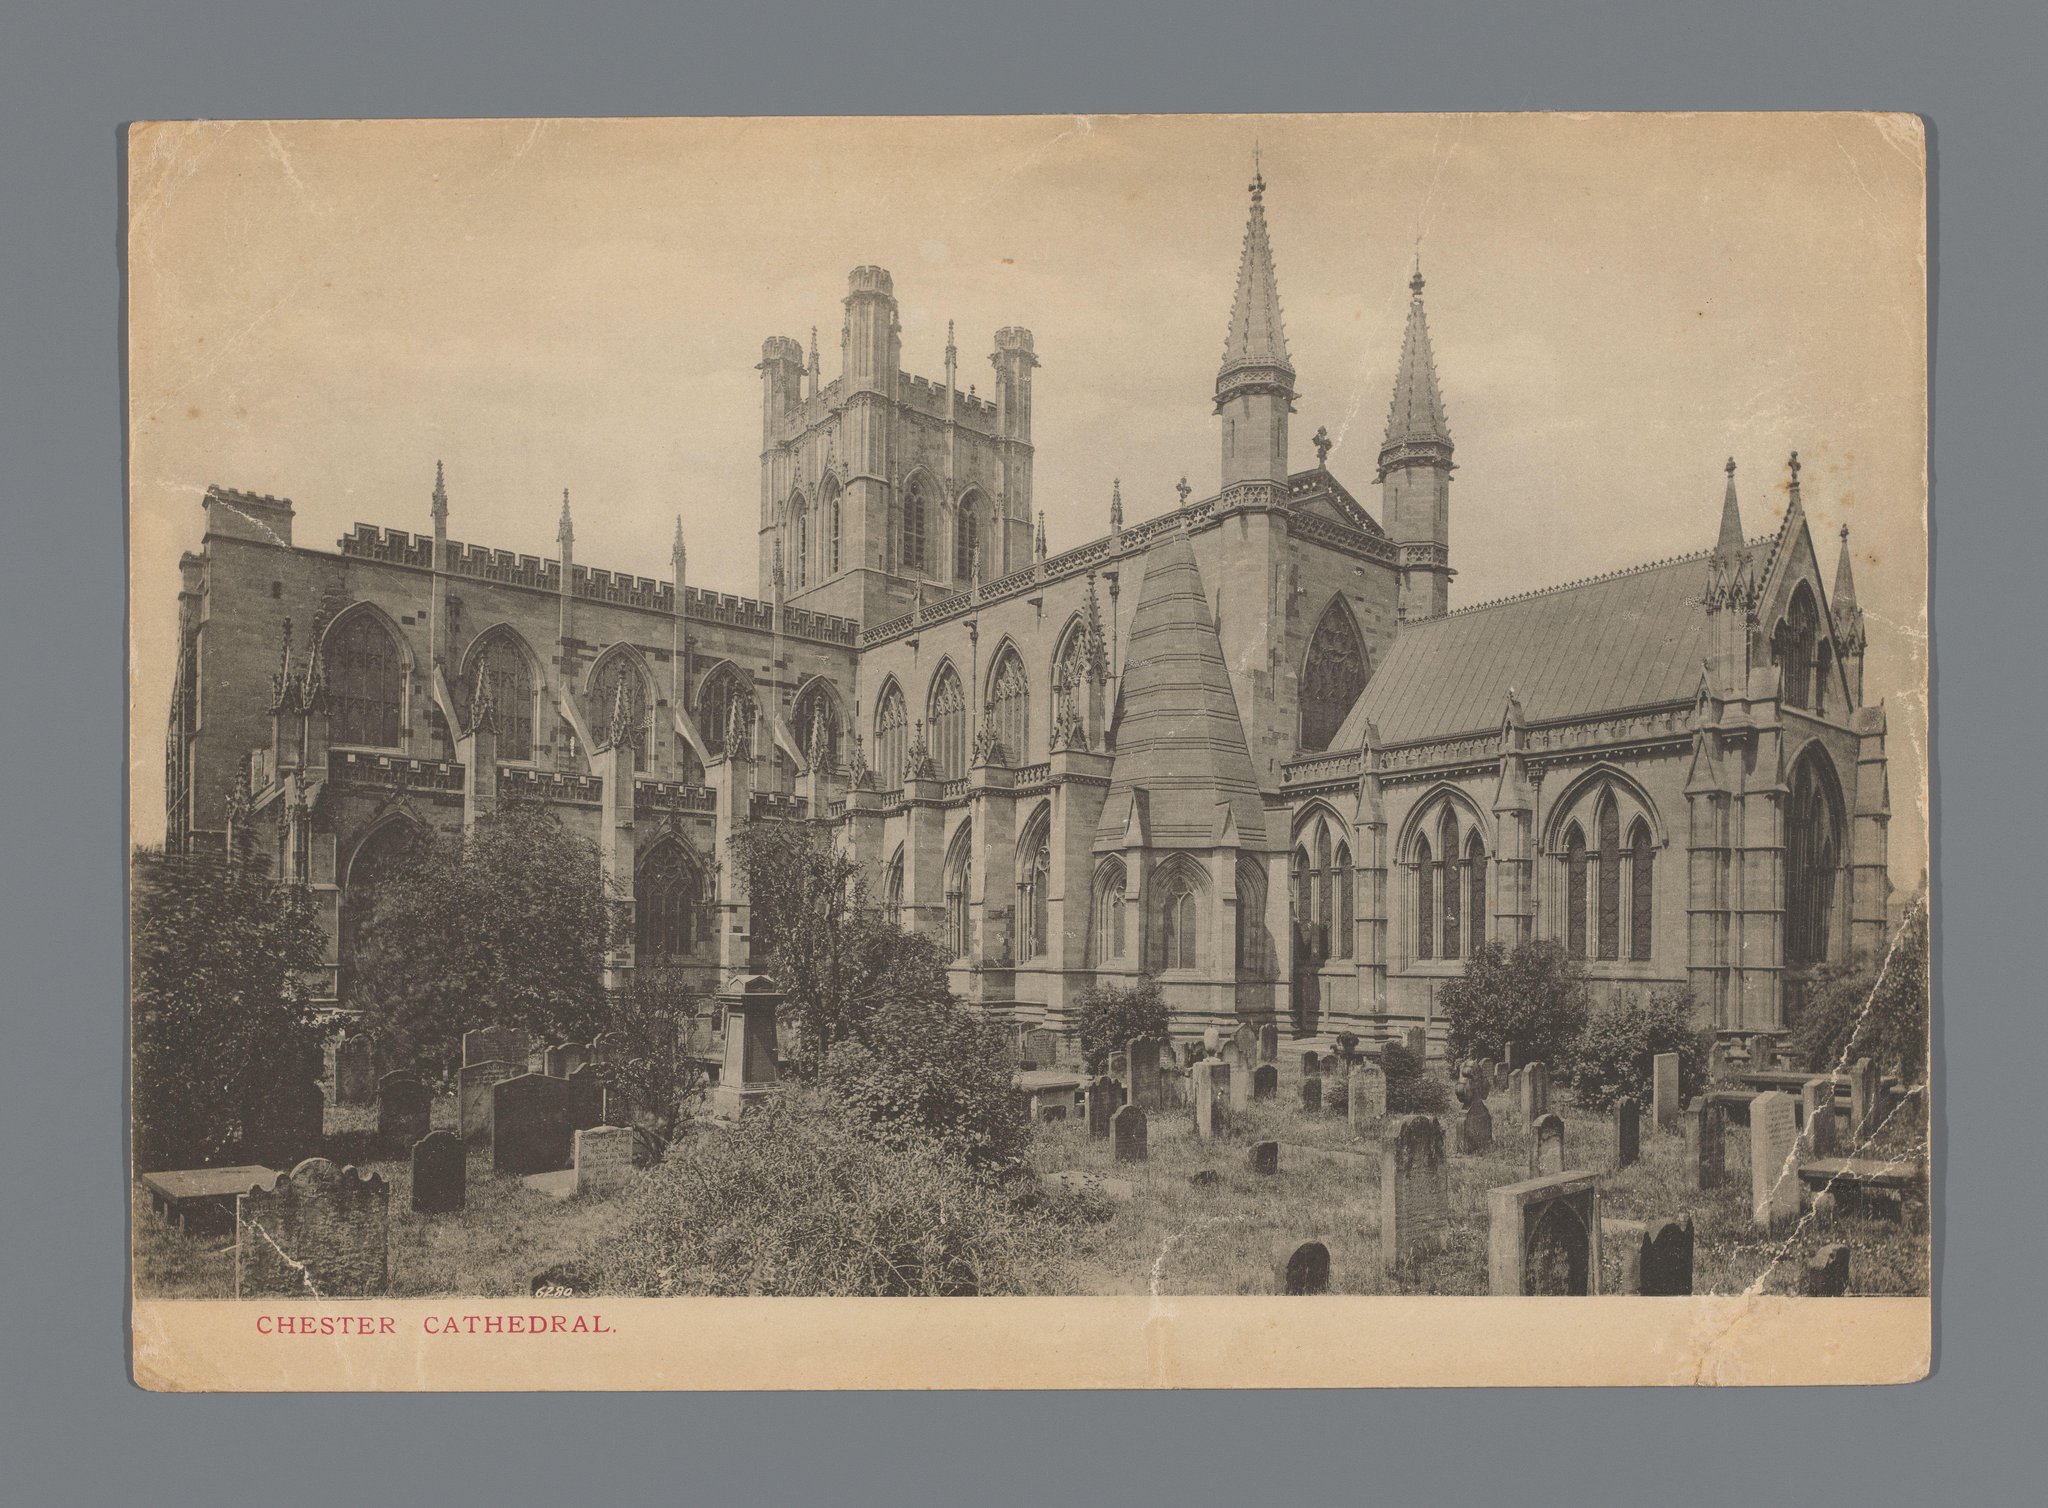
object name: photograph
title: Chester cathedral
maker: Anonymous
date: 1860-1930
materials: photographic support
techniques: photograph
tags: chester